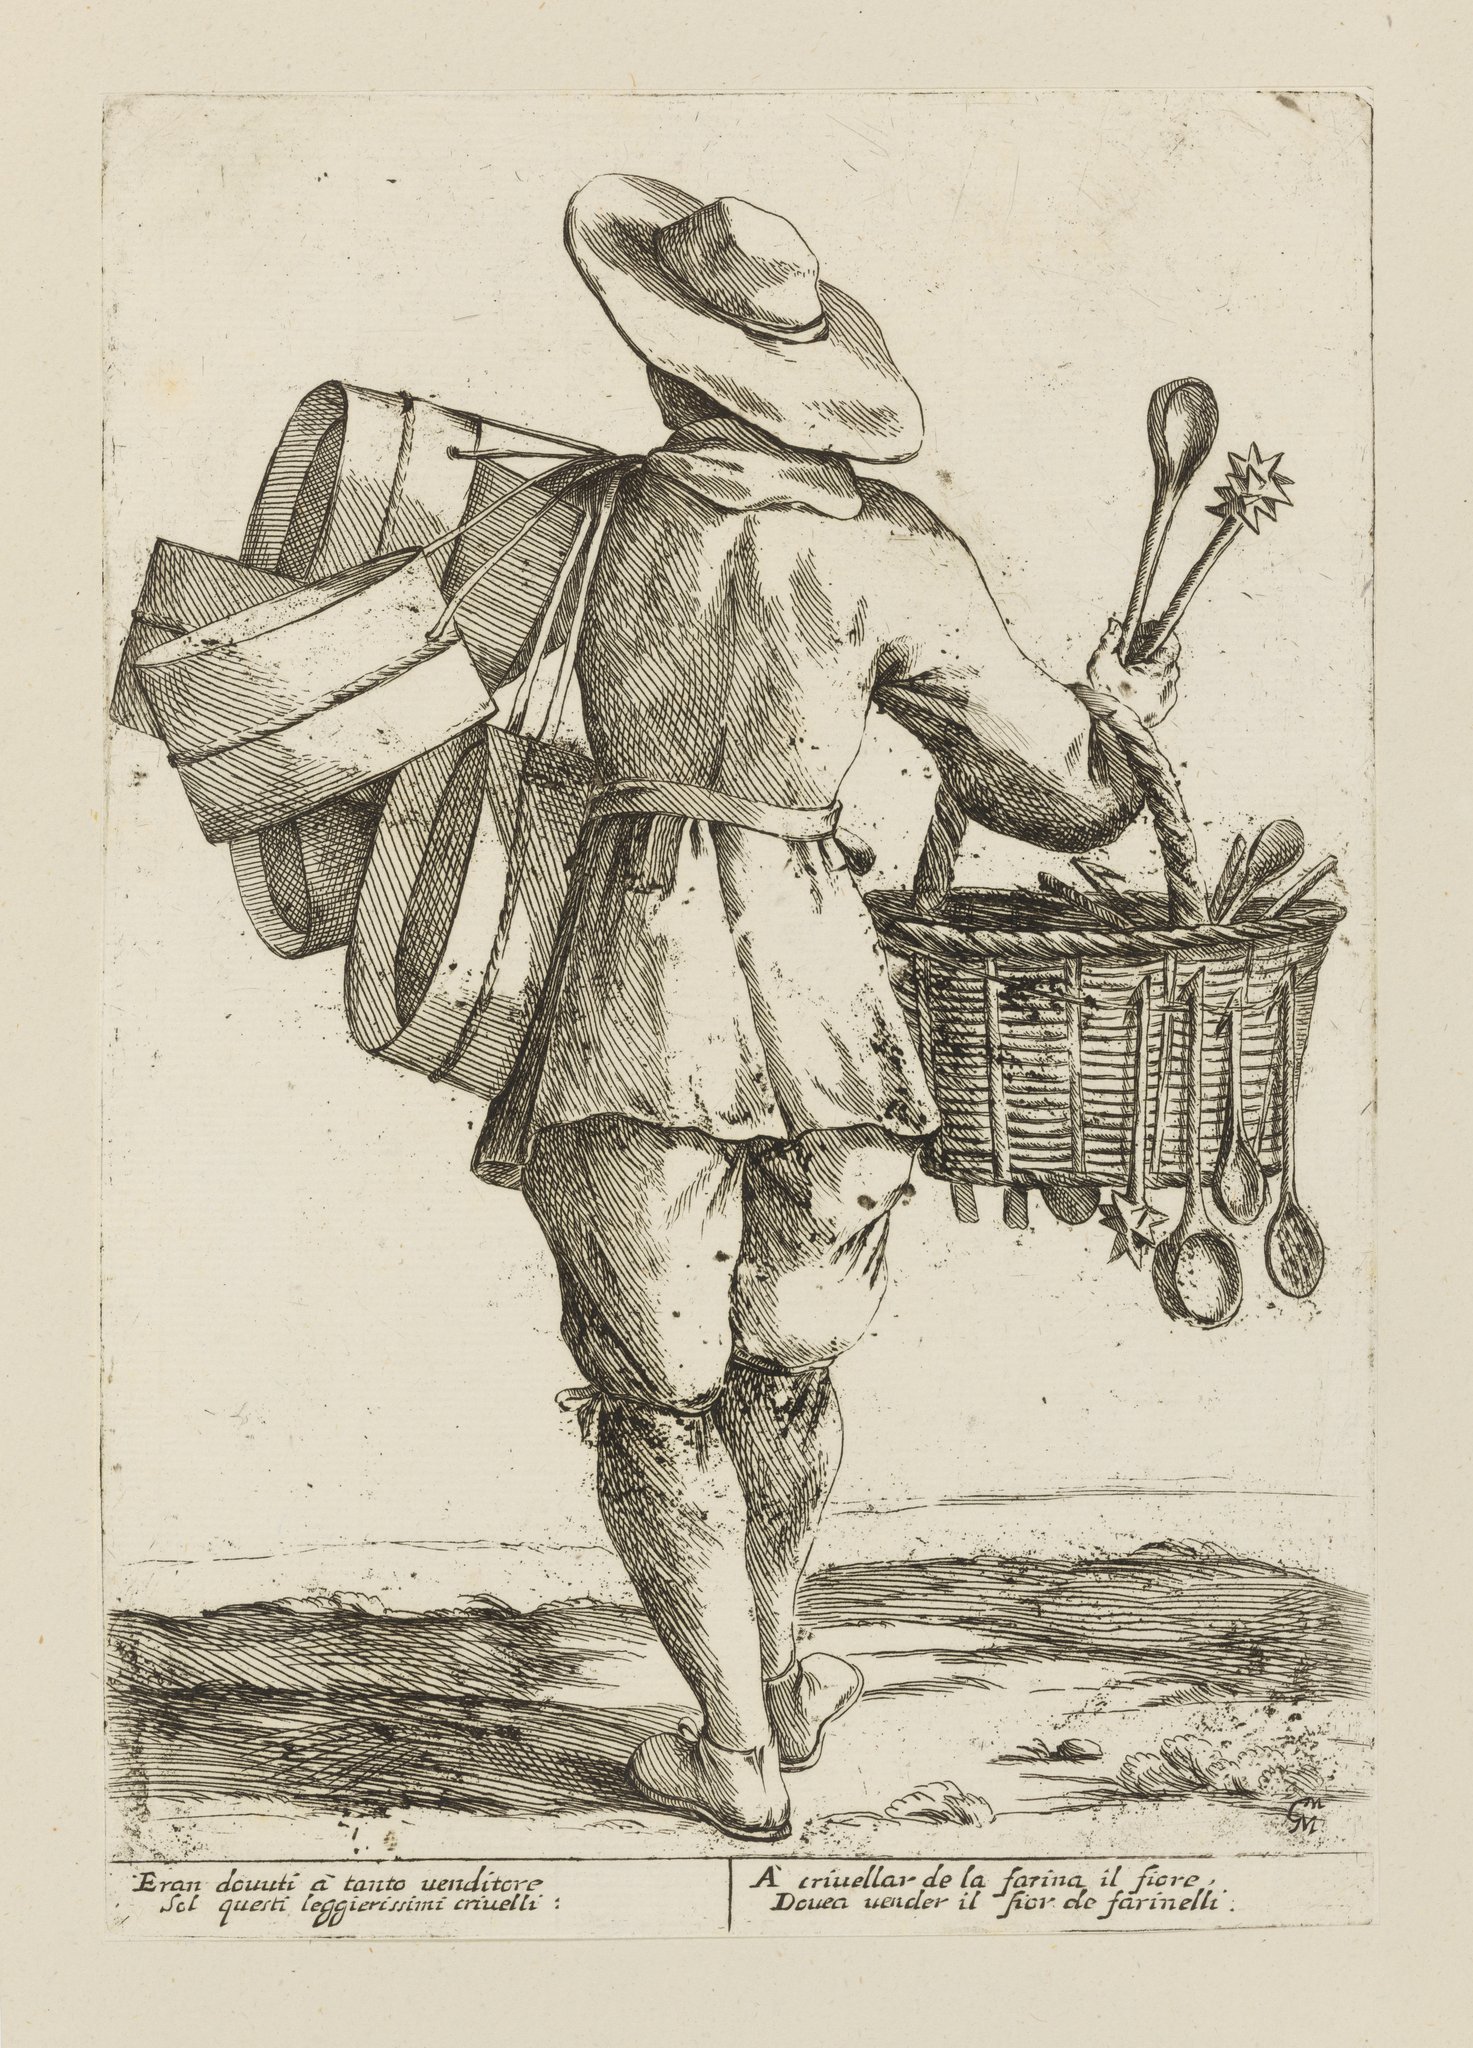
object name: print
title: Vendor of Sieves, from Di Bologna l'Arti per via D'An.ibal' Ca.rac, plate 12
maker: giuseppe maria mitelli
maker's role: artist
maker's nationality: italian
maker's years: 1634-1718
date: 1660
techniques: etching